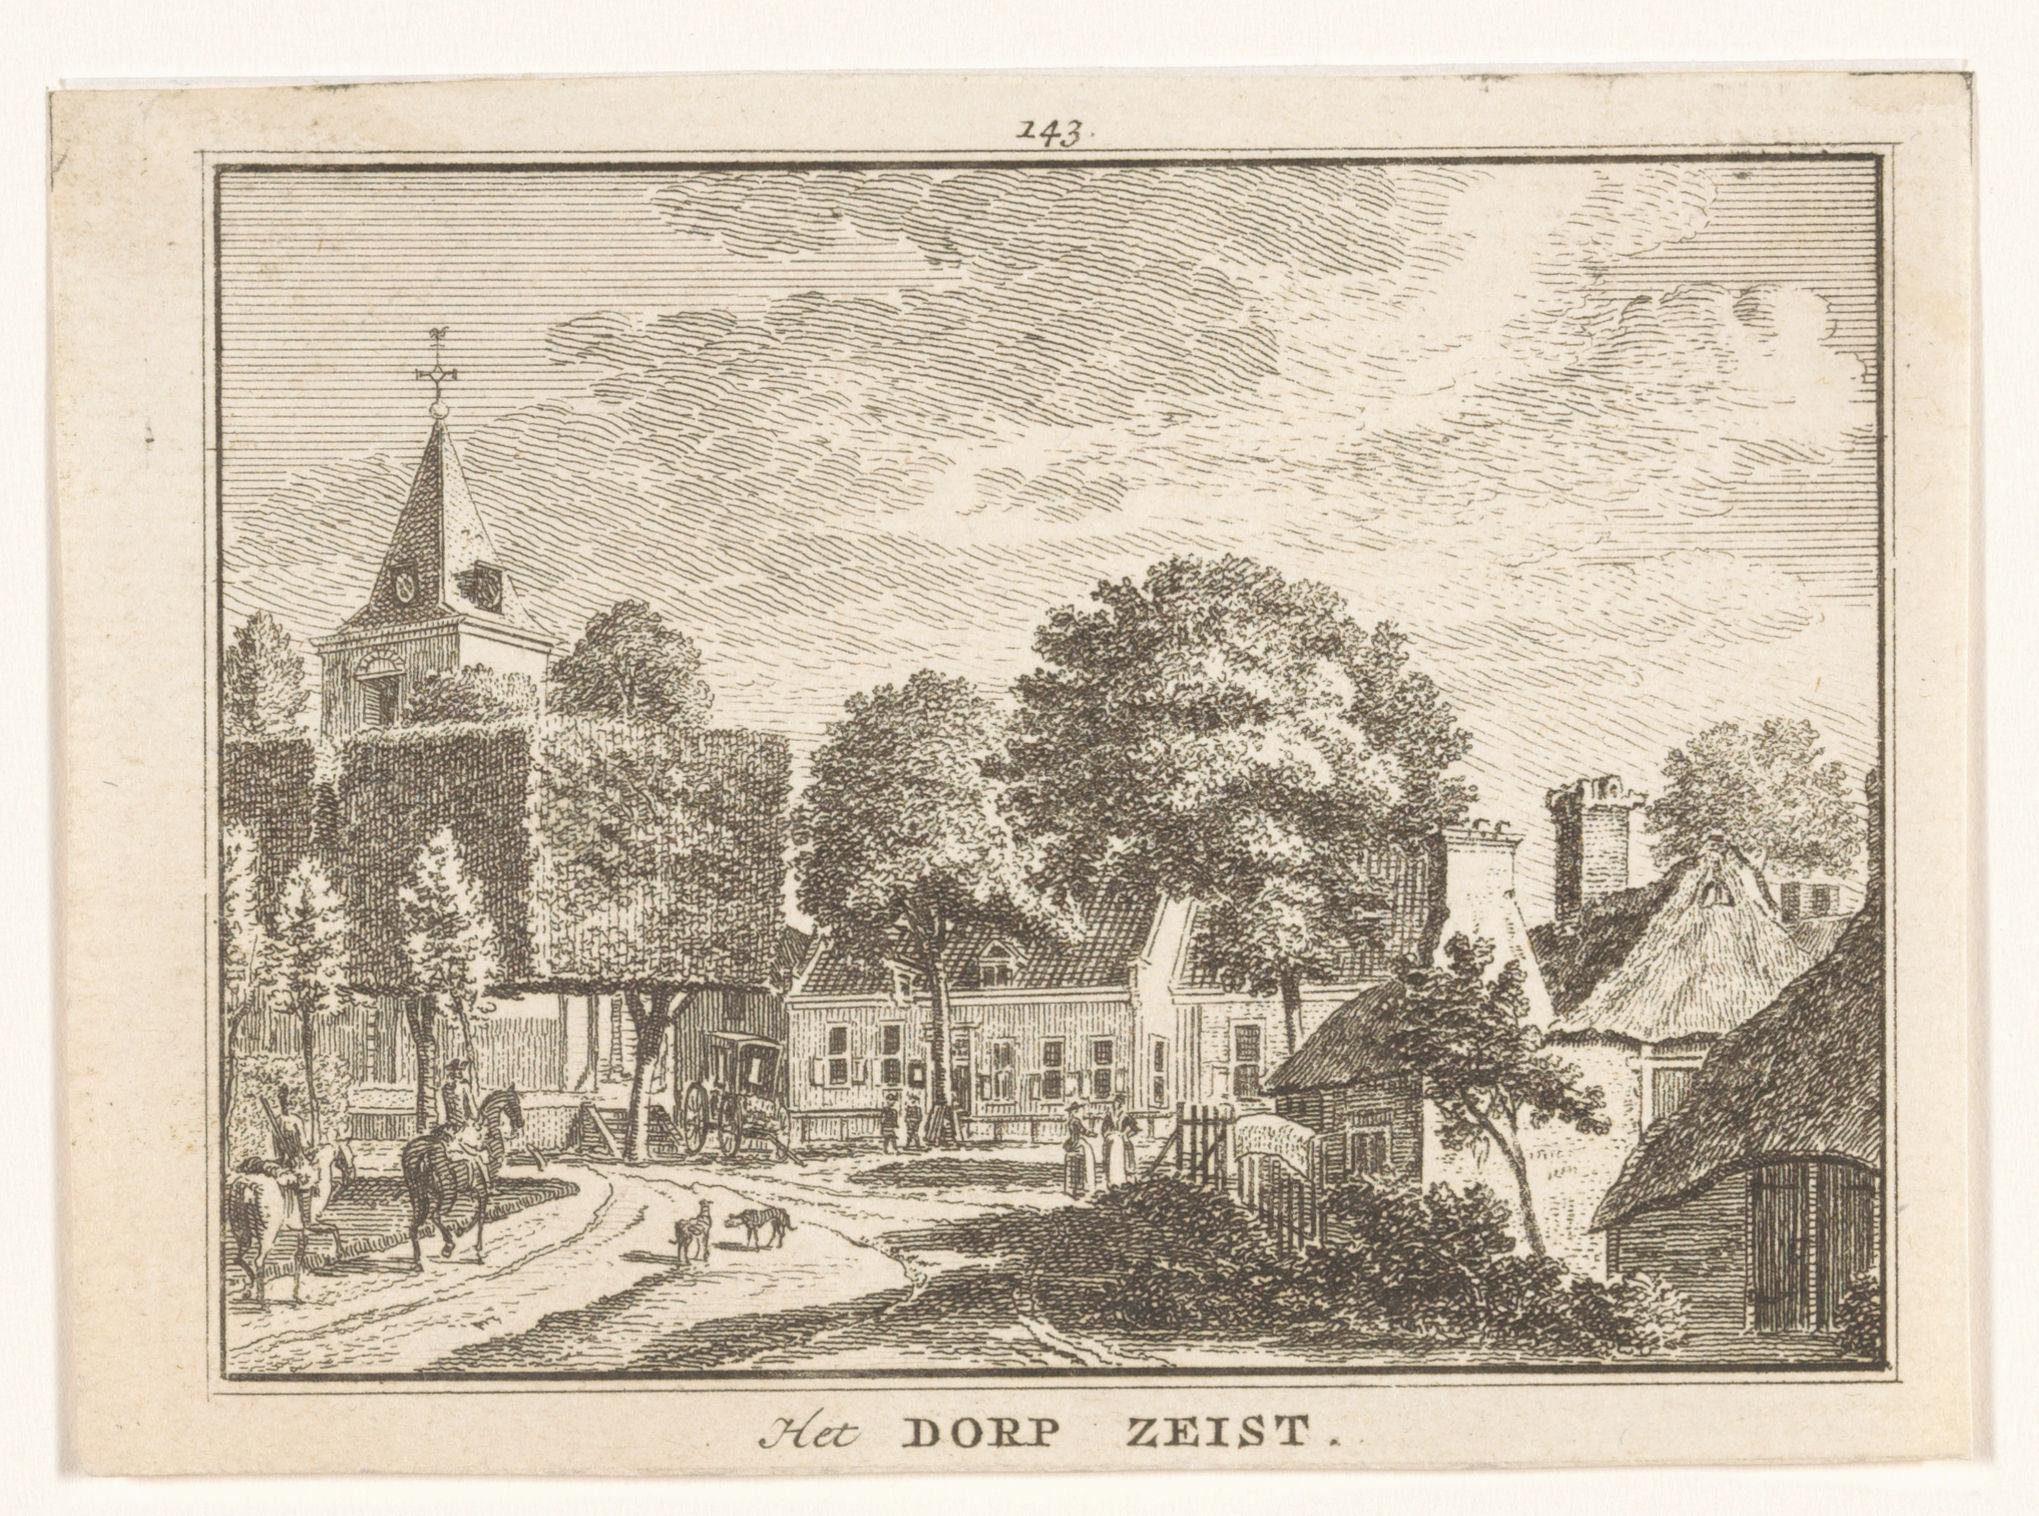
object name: print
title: Het dorp Zeist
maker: hendrik spilman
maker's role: draughtsman, painter, print maker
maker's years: 1721-1784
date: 1773-1792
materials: paper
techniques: engraving, etching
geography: haarlem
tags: church (exterior), public road in village (+ city(-scape) with figures, staffage), zeist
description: Prent ook gebruikt in: Het verheerlykt Nederland of kabinet van hedendaagsche gezigten van steden, dorpen (…). 9 delen. Amsterdam: Isaak Tirion en weduwe Isaak Tirion, 1745-1774, dl. 7, 8 of 9 (weduwe Isaak Tirion, 1773-1774), ill. 143. Of in: Nederlandsche tafereelen; of eene keurige verzameling van negen honderd fraaije gezigten van steden, dorpen, sloten, oudheden (….). 9 delen. Amsterdam: Jan de Groot, 1792, dl. 7, 8 of 9, ill. 143. Uit welke druk het huidige exemplaar precies komt is niet na te gaan.